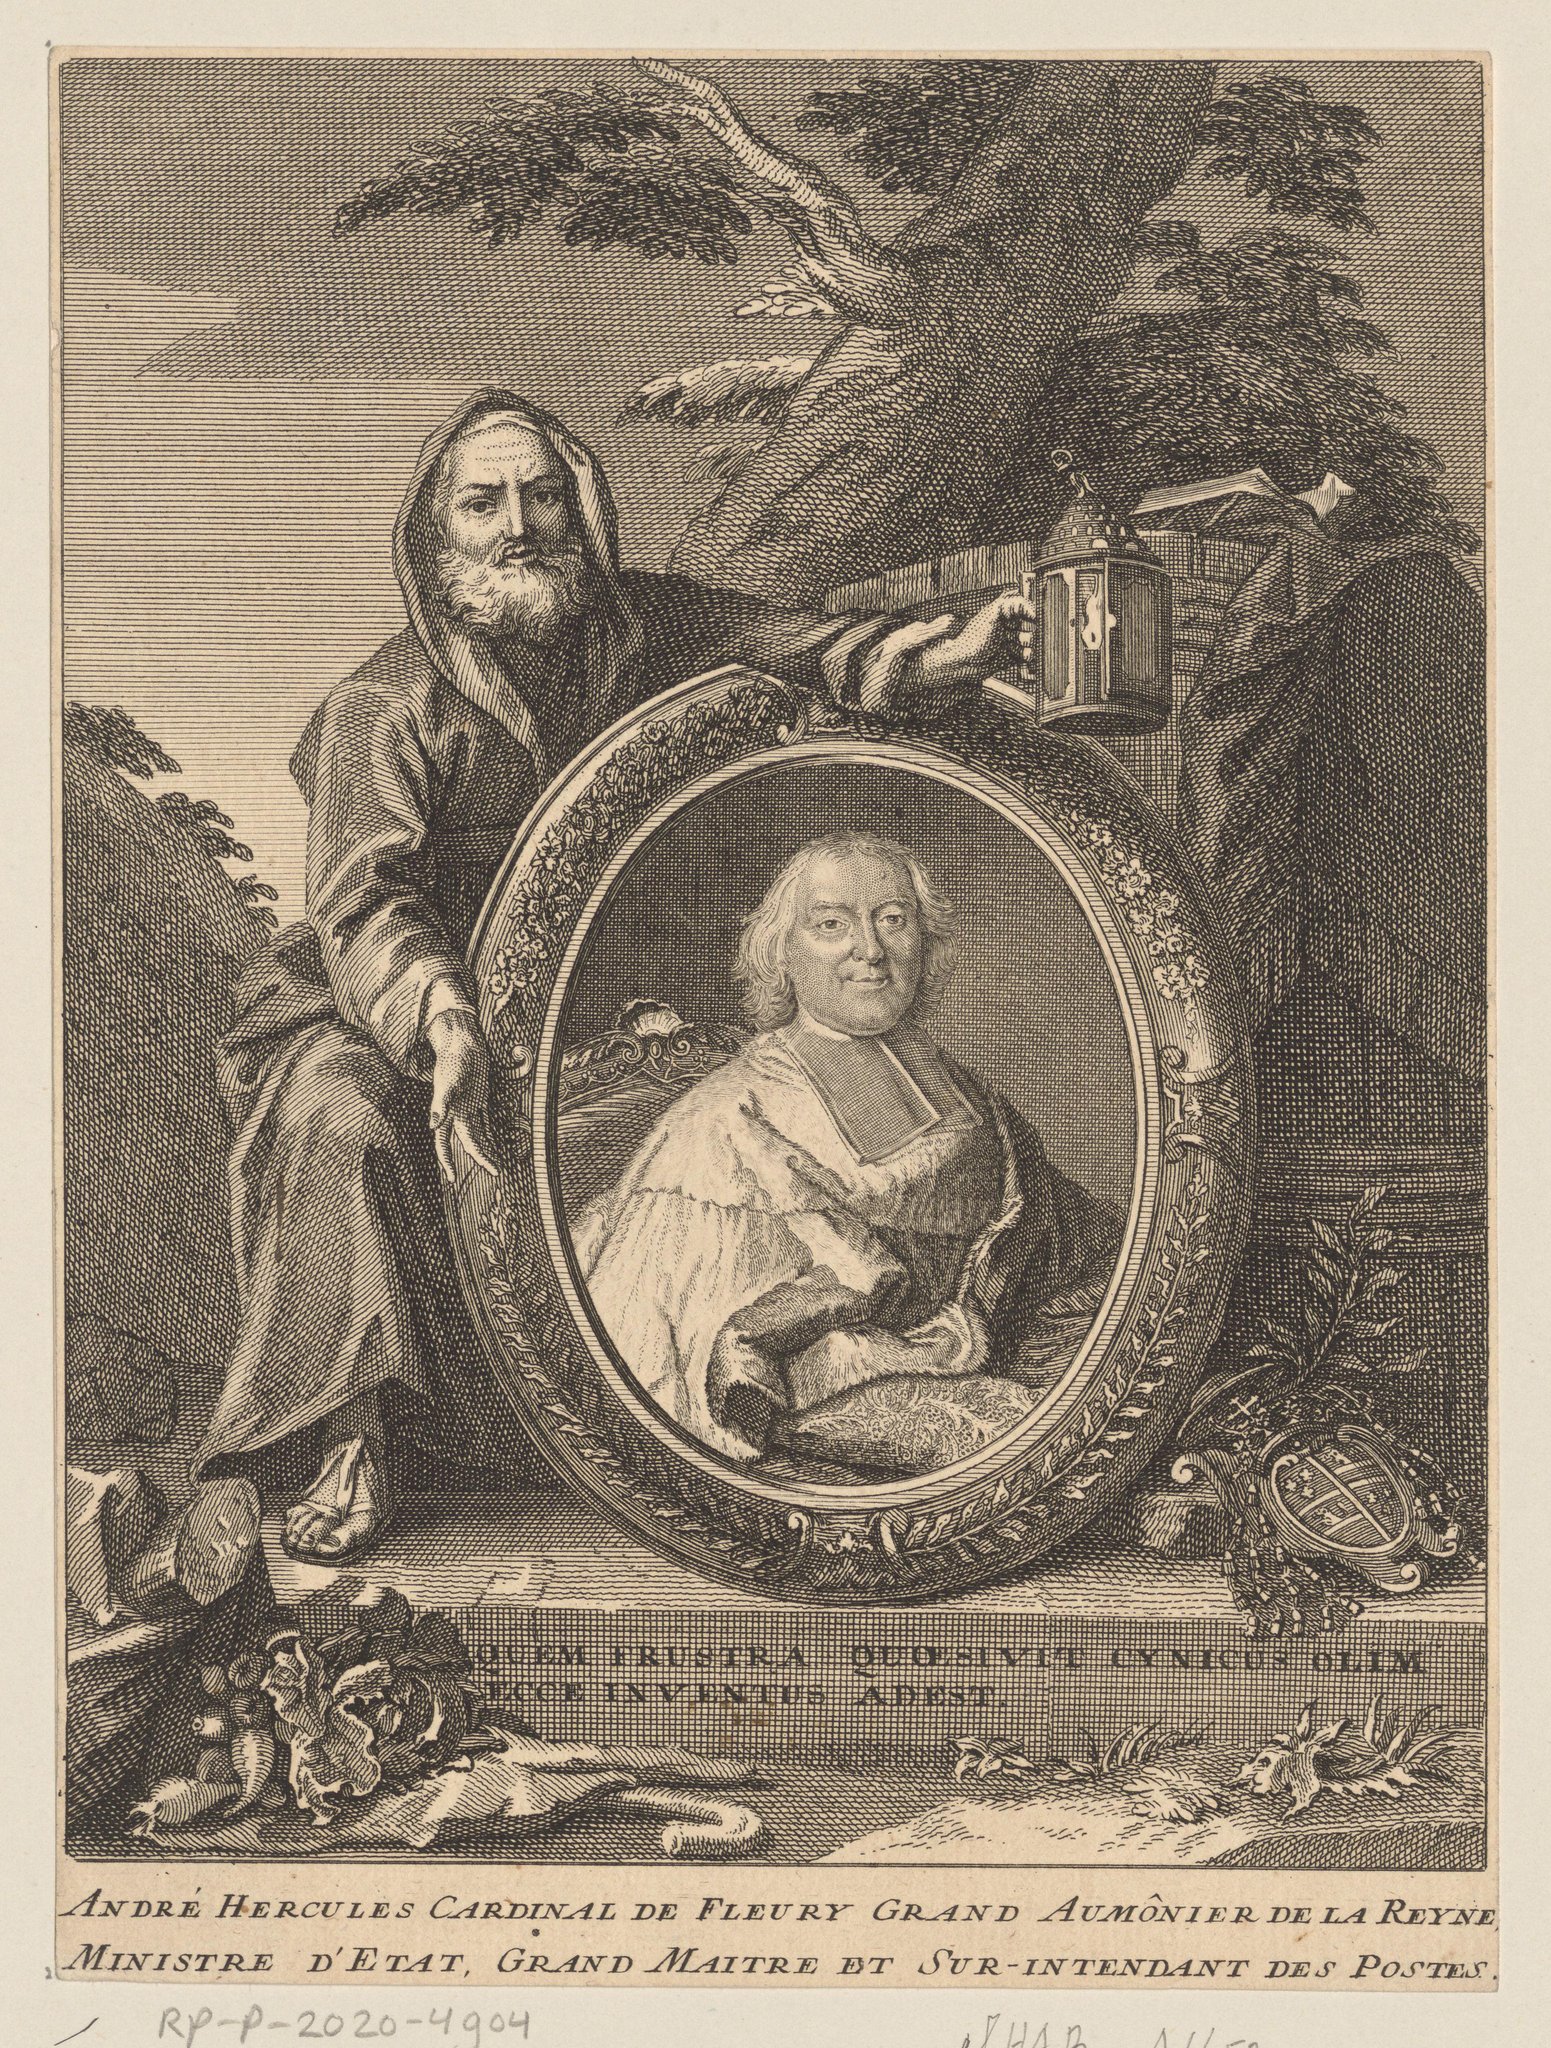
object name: print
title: Diogenes bij een portret van André-Hercule de Fleury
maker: Anonymous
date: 1728-1750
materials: paper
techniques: etching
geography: france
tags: france, historical persons, lantern, (story of) diogenes, the philosopher, armorial bearing, heraldry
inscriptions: inscription: ‘Le Portret [...] un Cardinal/ si Renommé pendant sa Vie/ [...] après bonne Copie/ D'un fort mauvaise Original/ [...] eté fait Par M.L.D.D.V.’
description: Een knielende Diogenes, met in zijn hand een lantaarn en op de achtergrond zijn ton, bij een portret van André-Hercule de Fleury in een ovaal ornamenteel medaillon. Met onderschrift in het Frans.